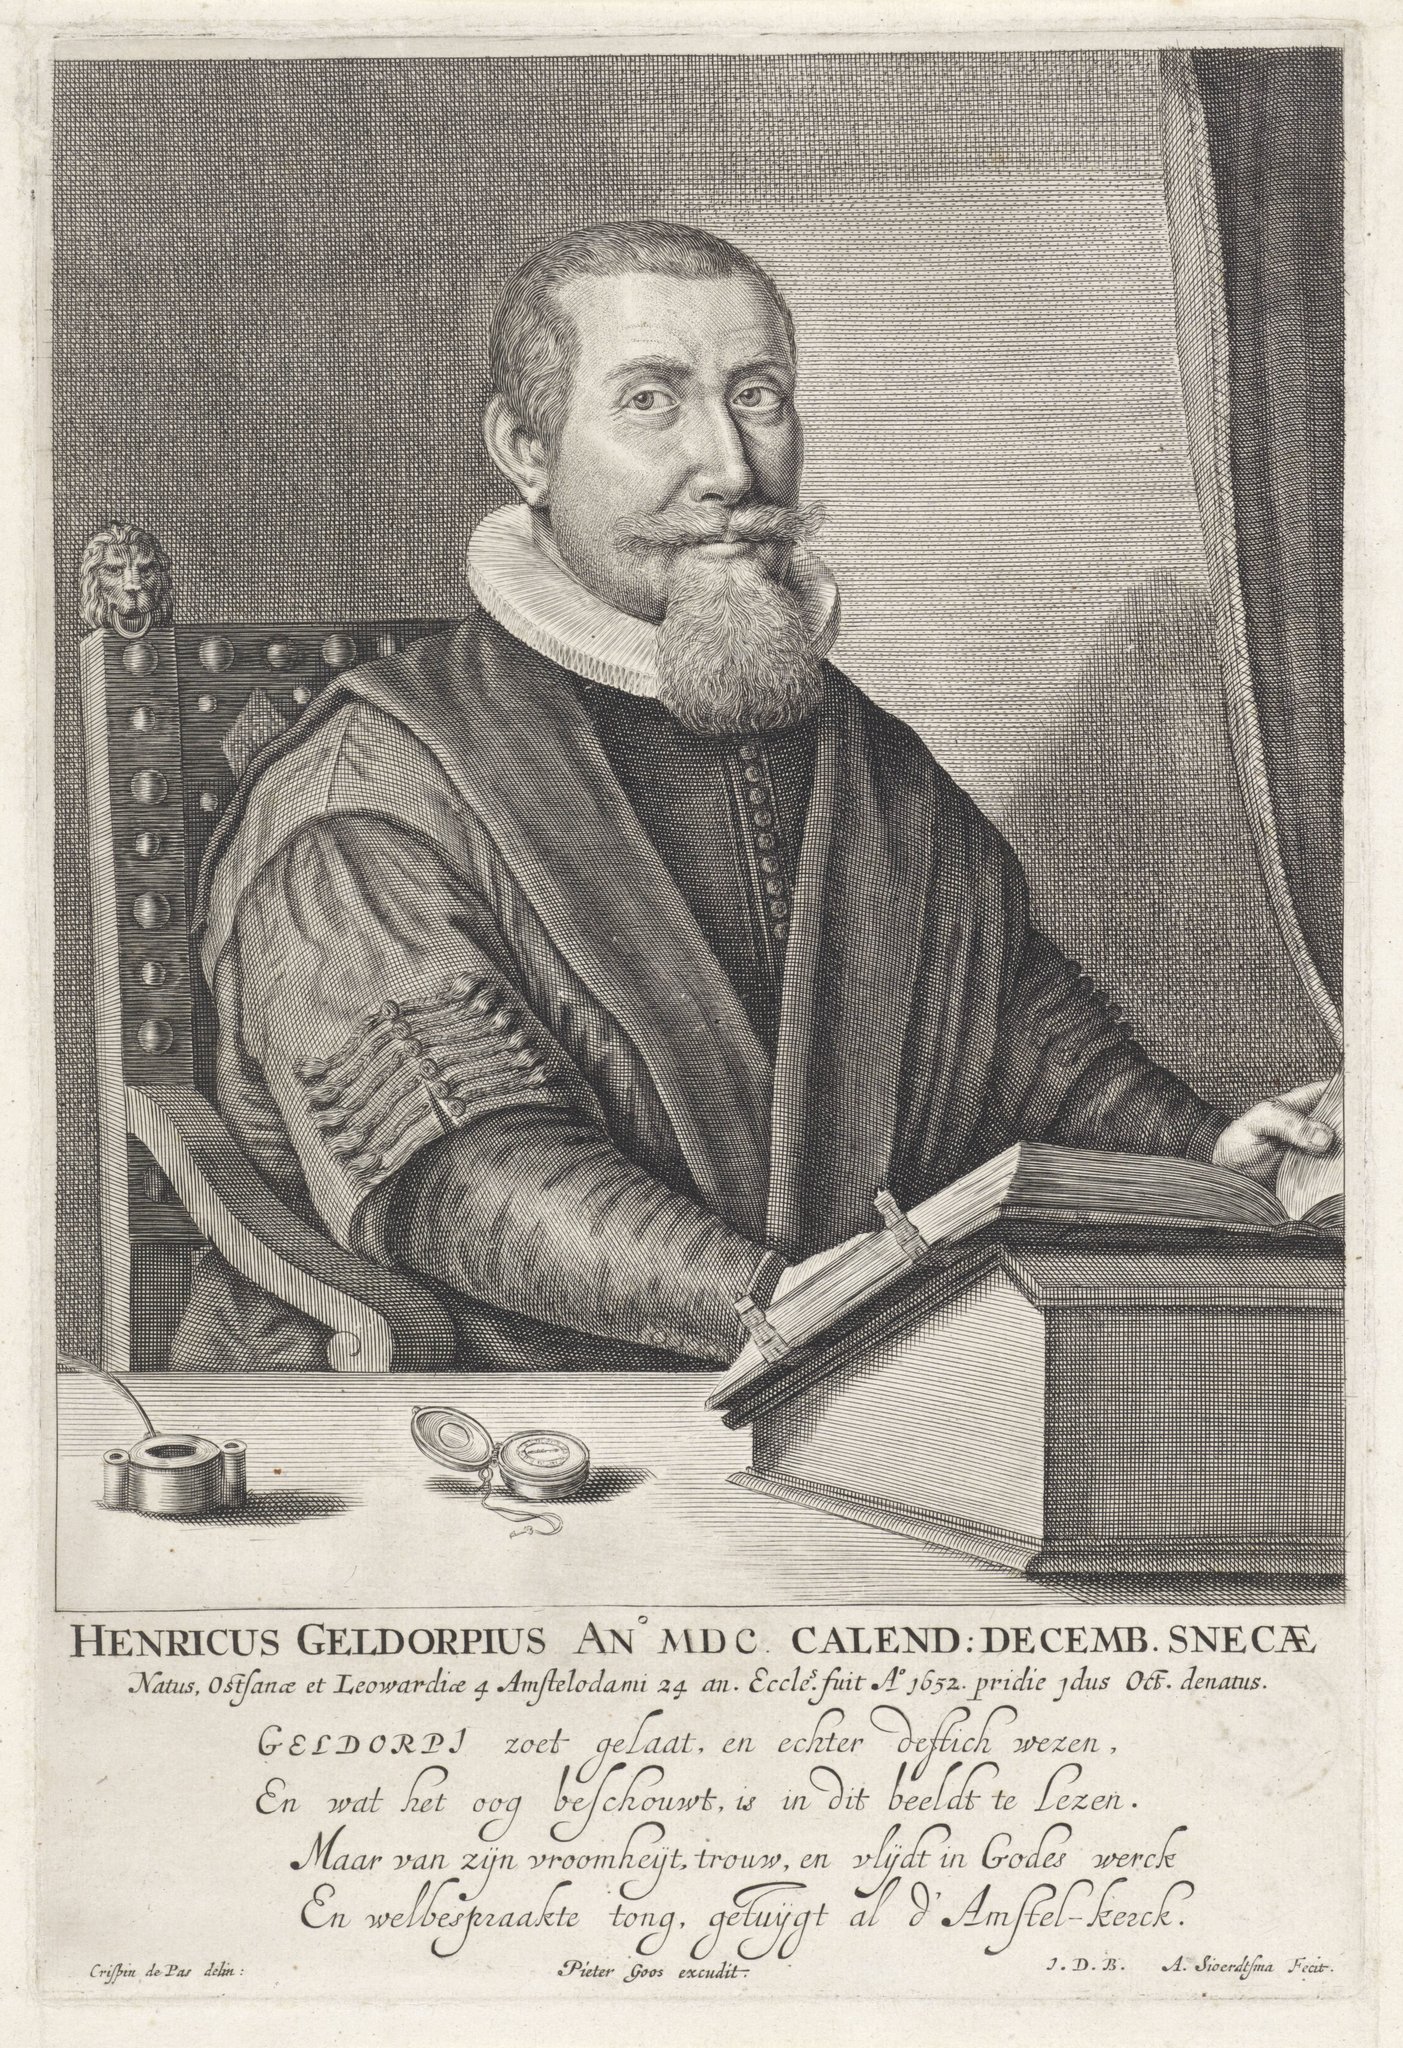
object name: print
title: Portret van Henricus Geldorp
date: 1652-1654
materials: paper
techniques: engraving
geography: amsterdam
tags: sneek, predikant, henricus geldorp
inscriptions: collector's mark: Lugt 240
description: Portret van de predikant Henricus Geldorp. Hij zit aan een tafel met daarop een lezenaar met boek. Op tafel ligt een zakhorloge. Daarnaast een inktpot. Onder het portret in het Latijn zijn naam, leefjaren en functie. Daaronder een Nederlandstalig lofdicht. Kopie in spiegelbeeld naar de gelijknamige prent van Crispijn van de Passe (II).